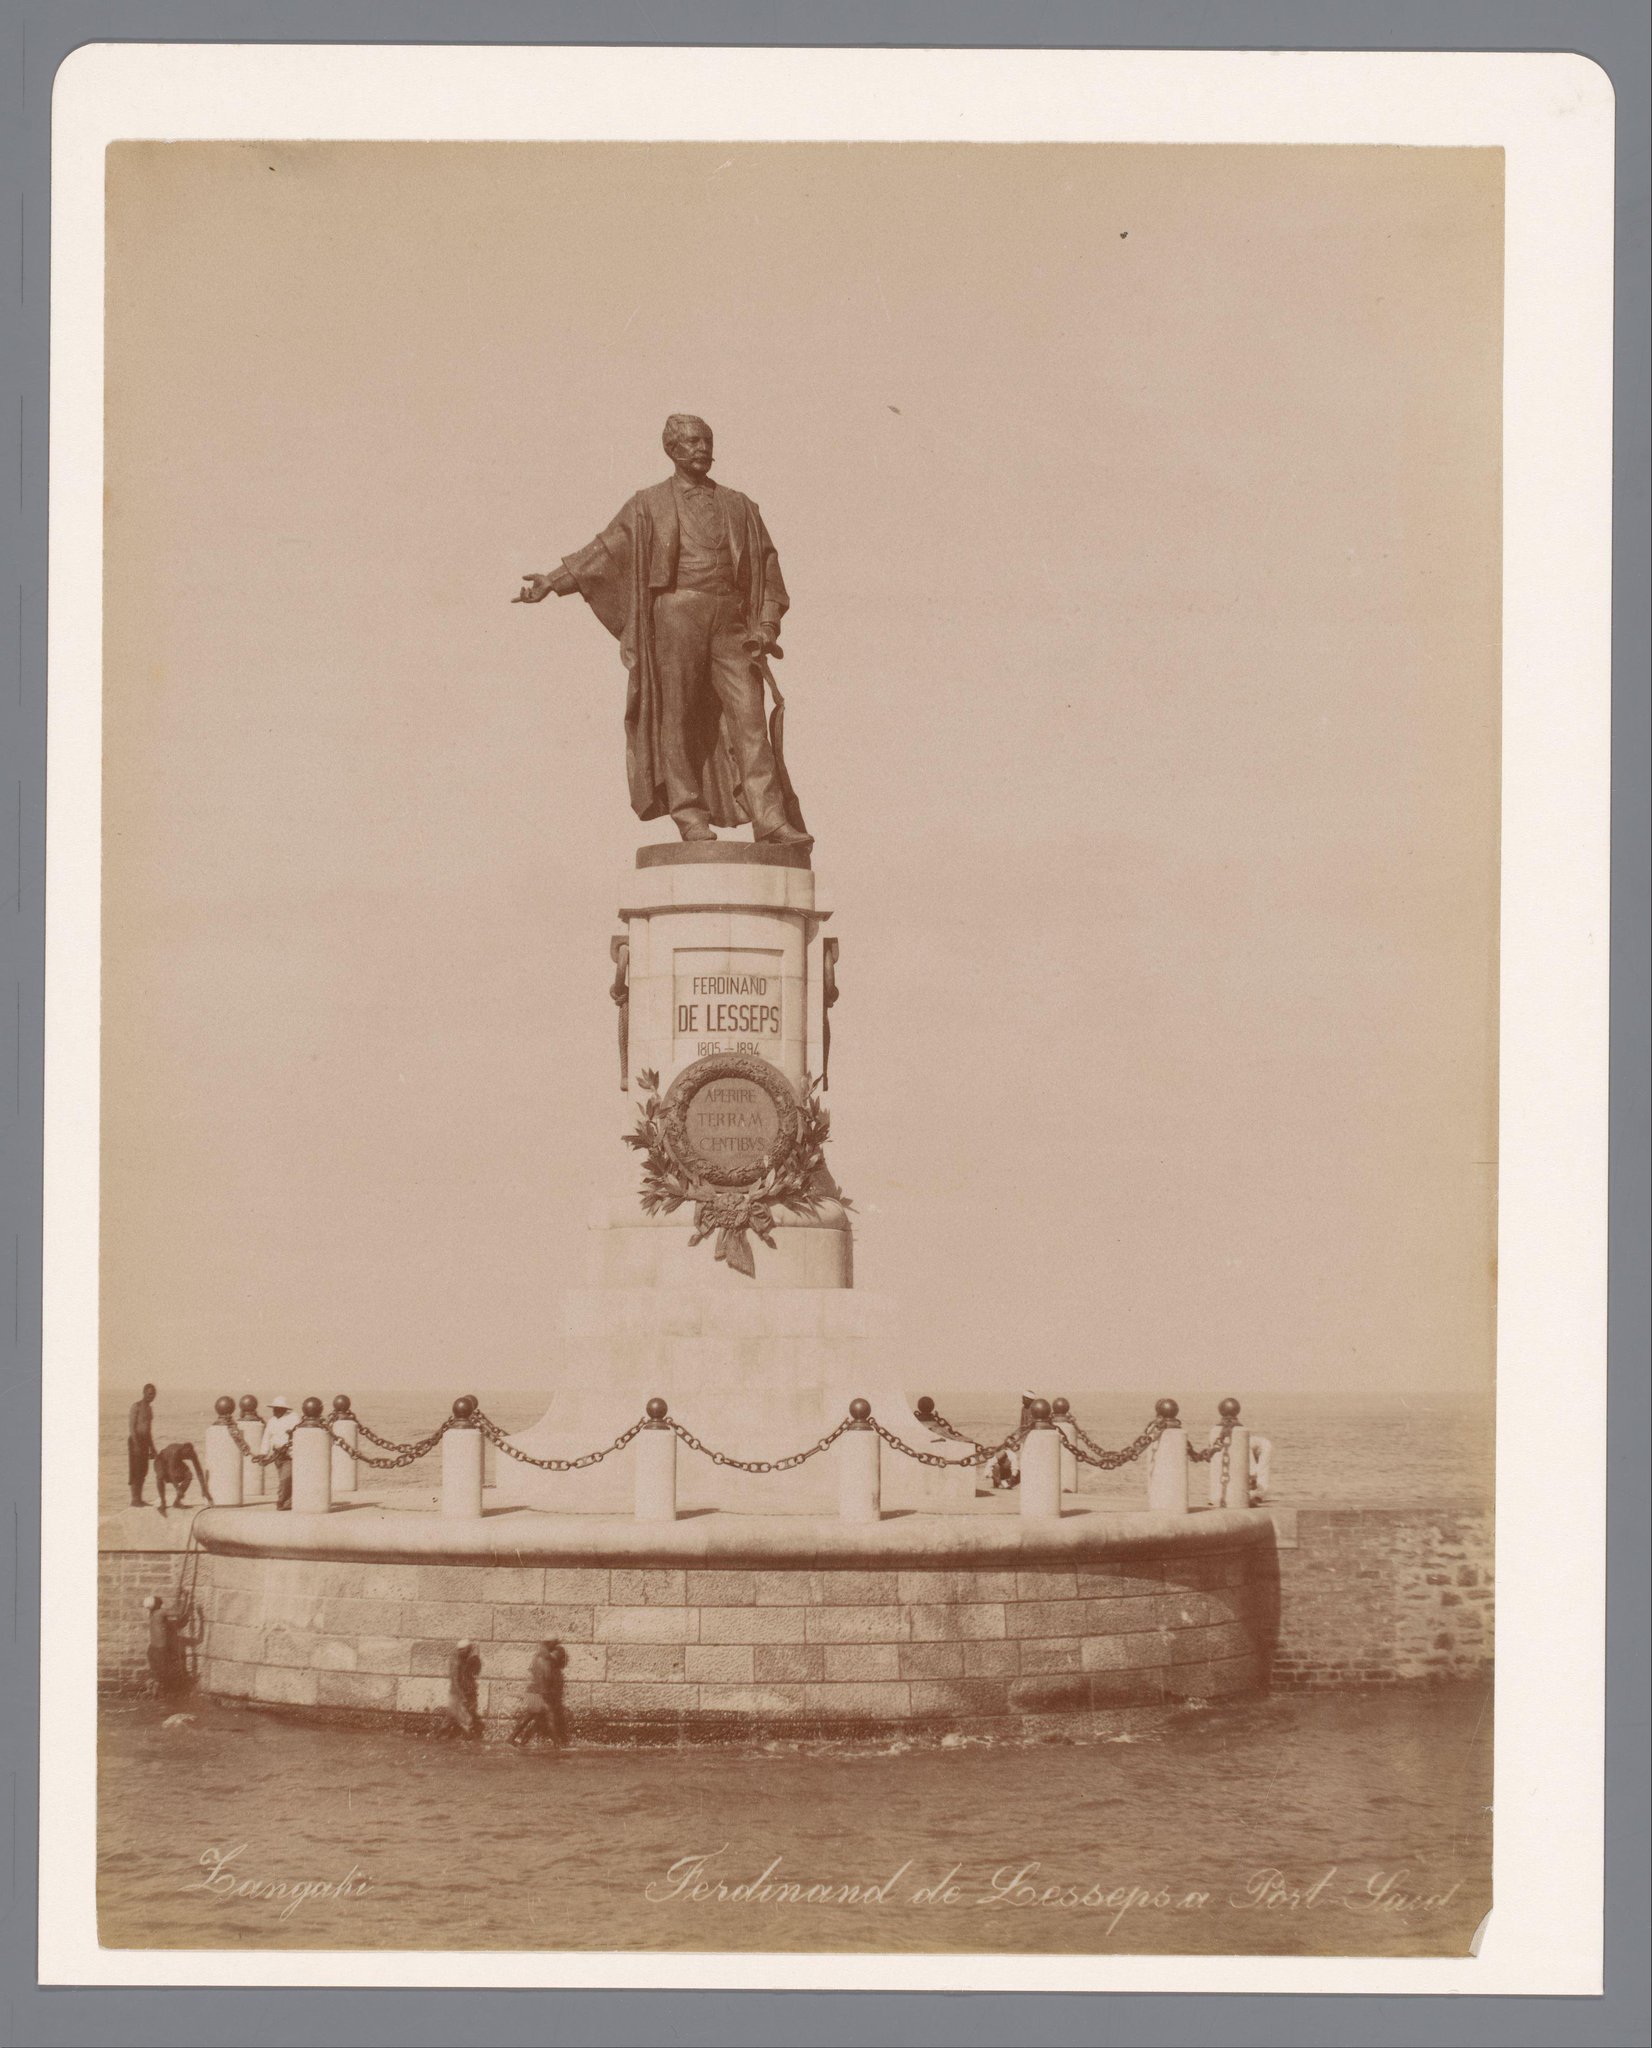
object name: photograph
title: Ferdinand de Lesseps a Port Said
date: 1894-1910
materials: paper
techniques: albumen print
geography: port said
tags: france, engineer, monument, statue